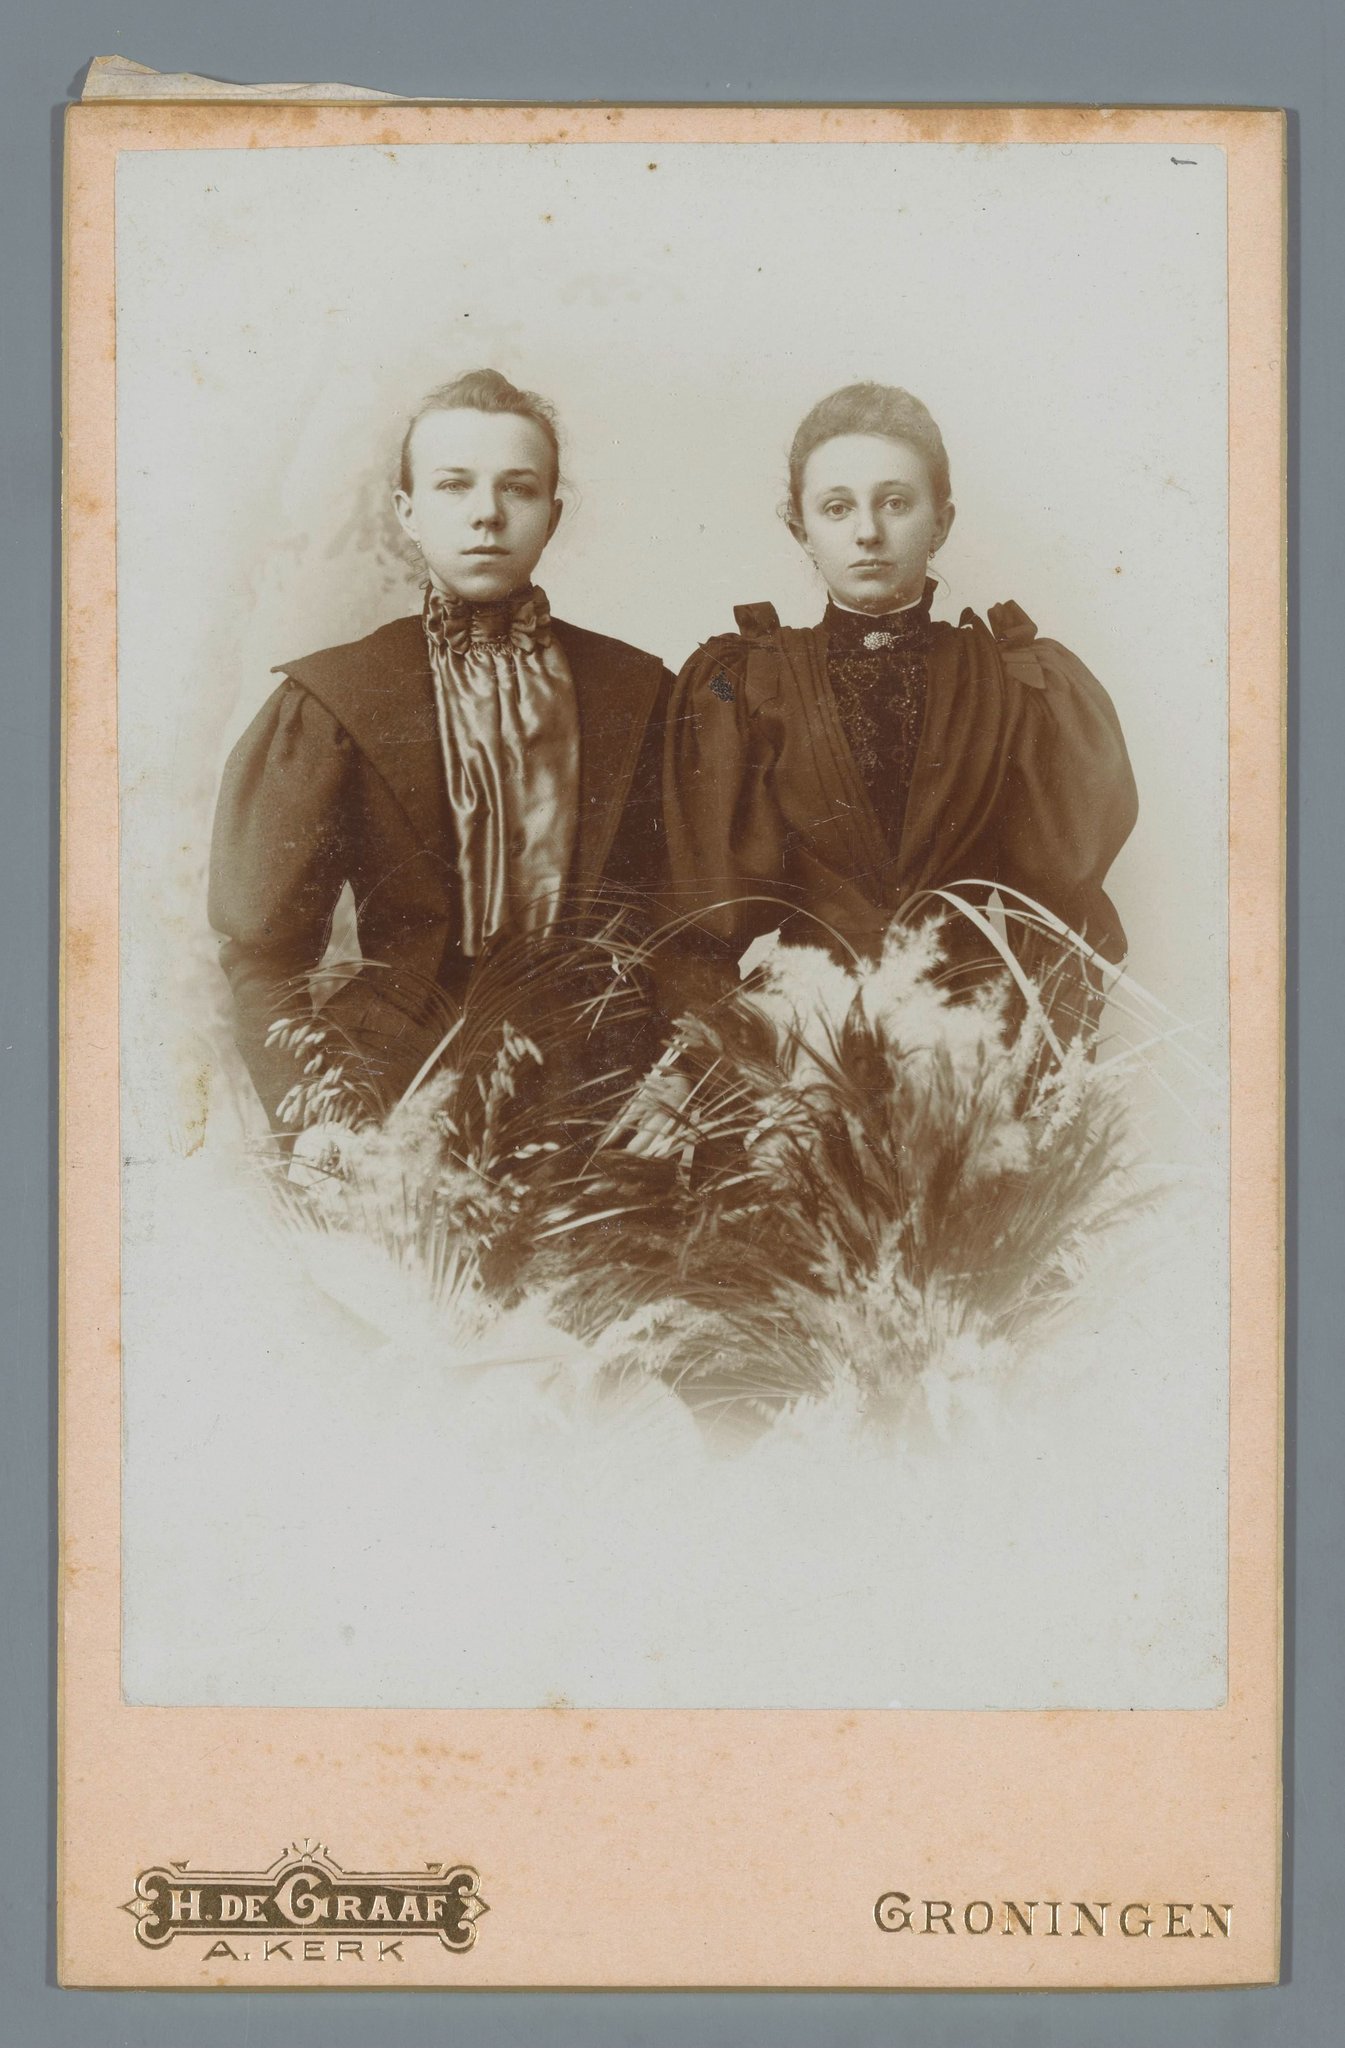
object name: cabinet photograph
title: Portret van twee meisjes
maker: h. de graaf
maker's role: fotograaf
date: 1880-1910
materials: cardboard, photographic support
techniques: collodion silver print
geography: groningen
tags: flowers, adolescent, young woman, maiden, child (at home) - aa - girl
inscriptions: name: ‘links. Geertje [...]annan geh. met Dirk rechts. Bauwine Hiskia Boerma geb. 24 sept. 1870.’